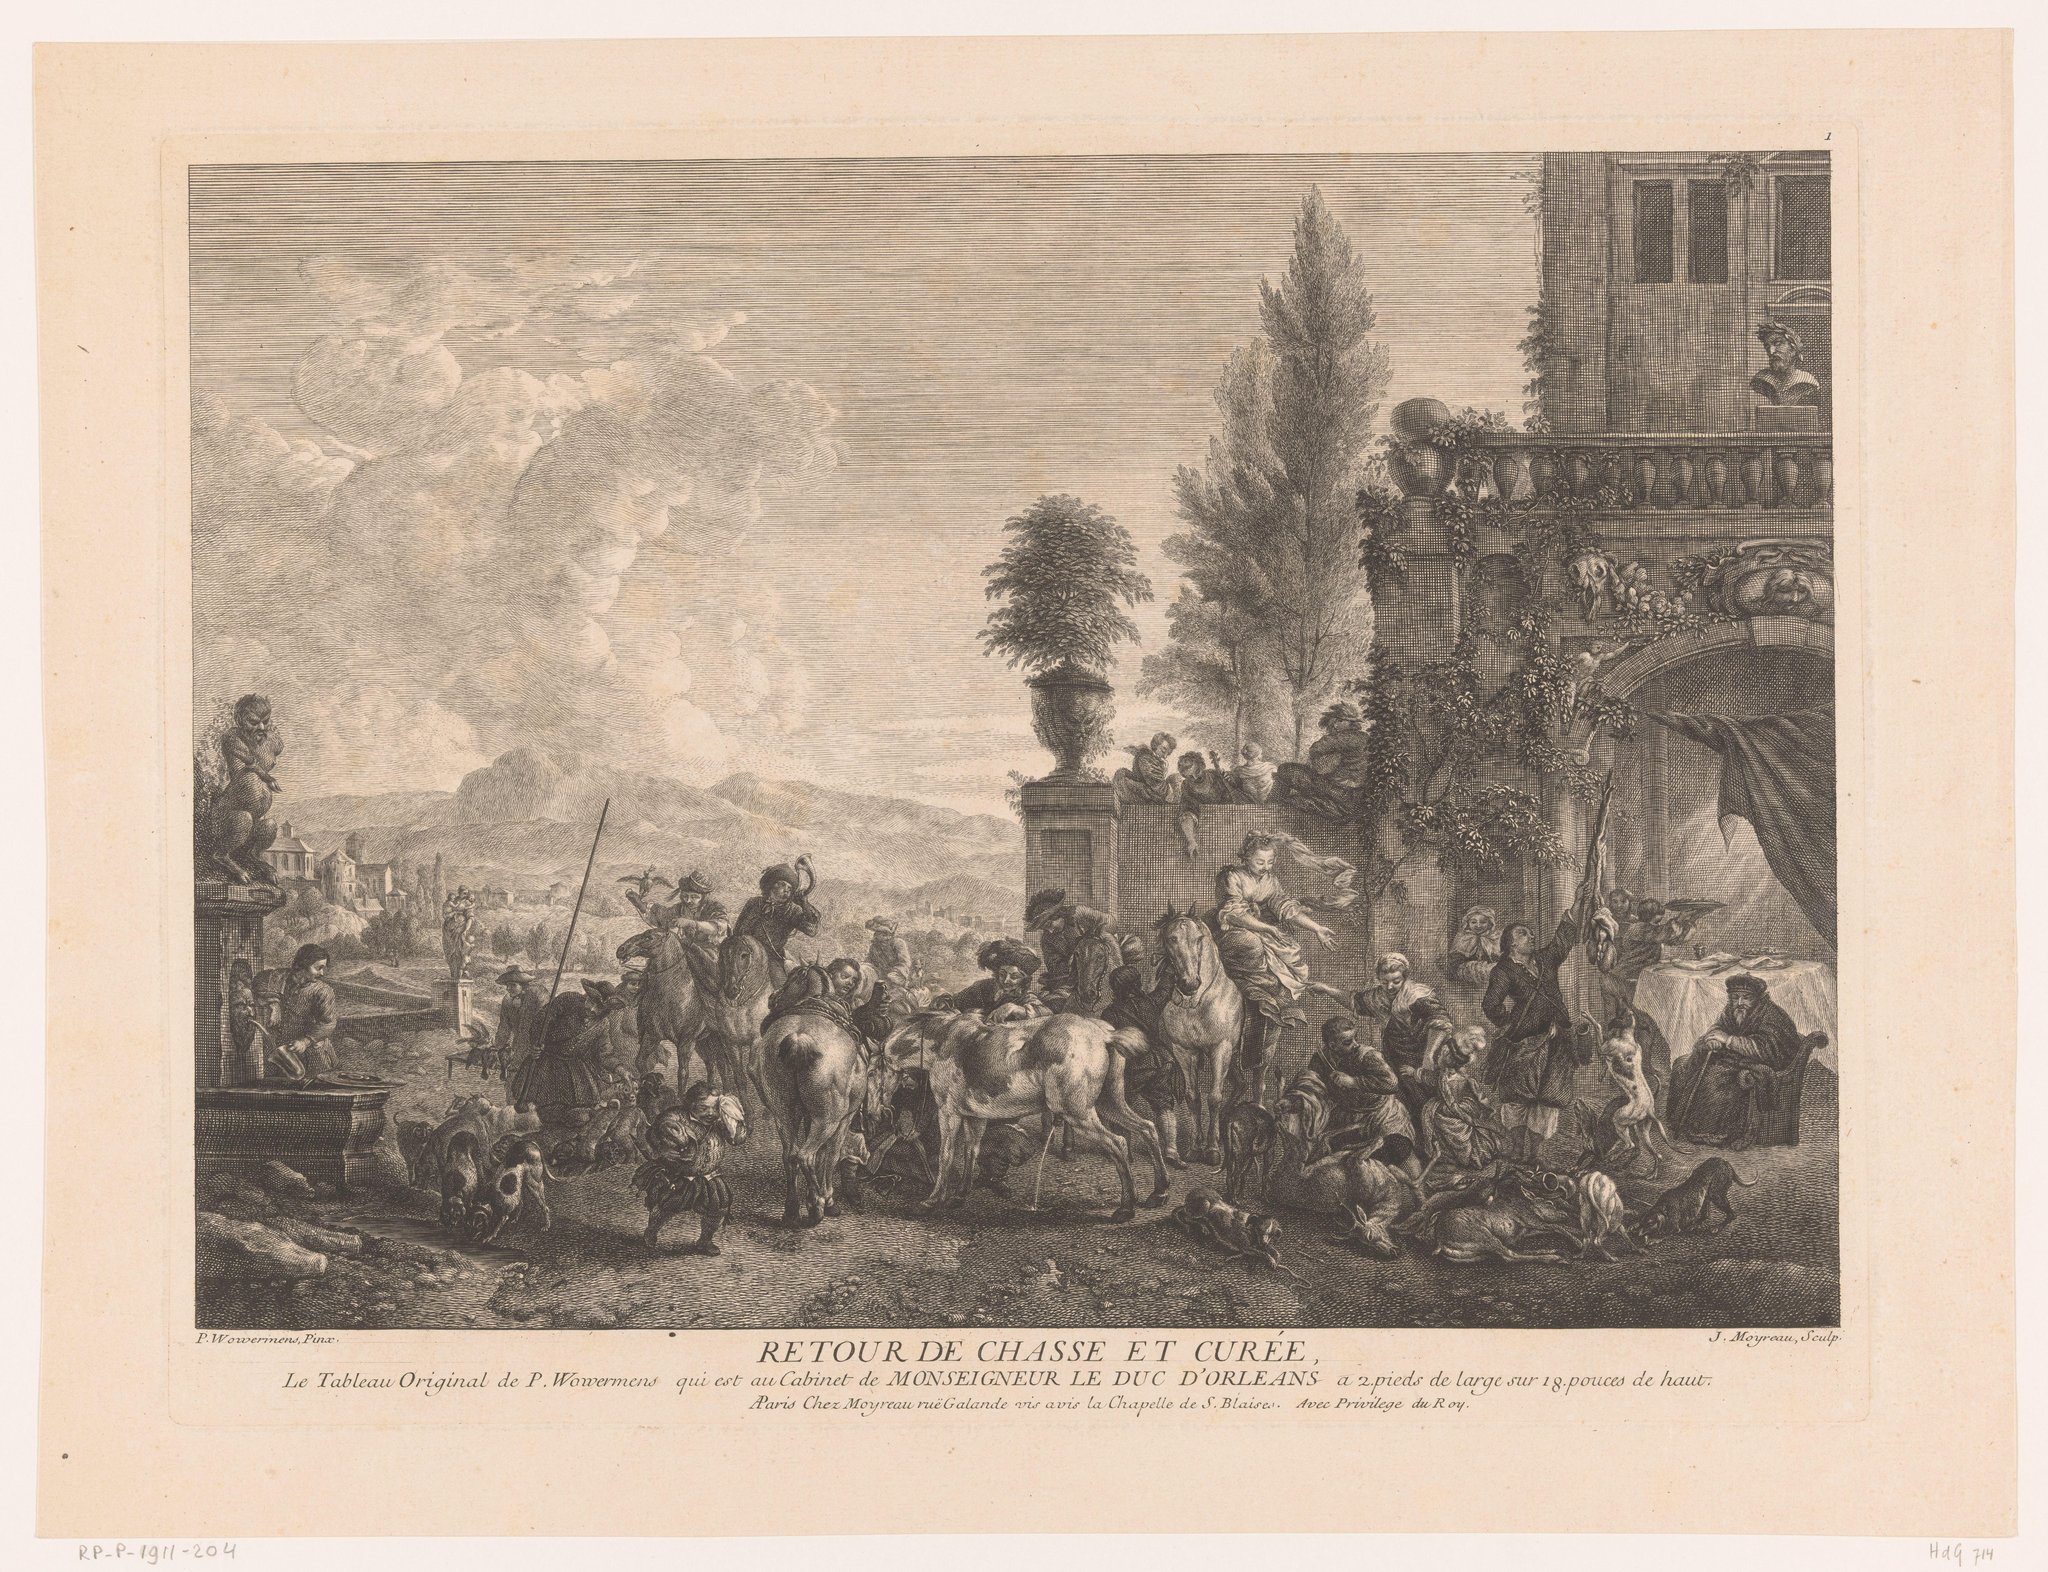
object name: print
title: Retour de chasse et curée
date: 1733-1762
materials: paper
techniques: engraving, etching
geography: france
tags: return from the hunt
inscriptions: collector's mark: Lugt 2228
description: Maakt deel uit van een serie van 89 prenten te dateren tussen ca. 1733-1762, naar het geschilderde oeuvre van Philips Wouwerman.